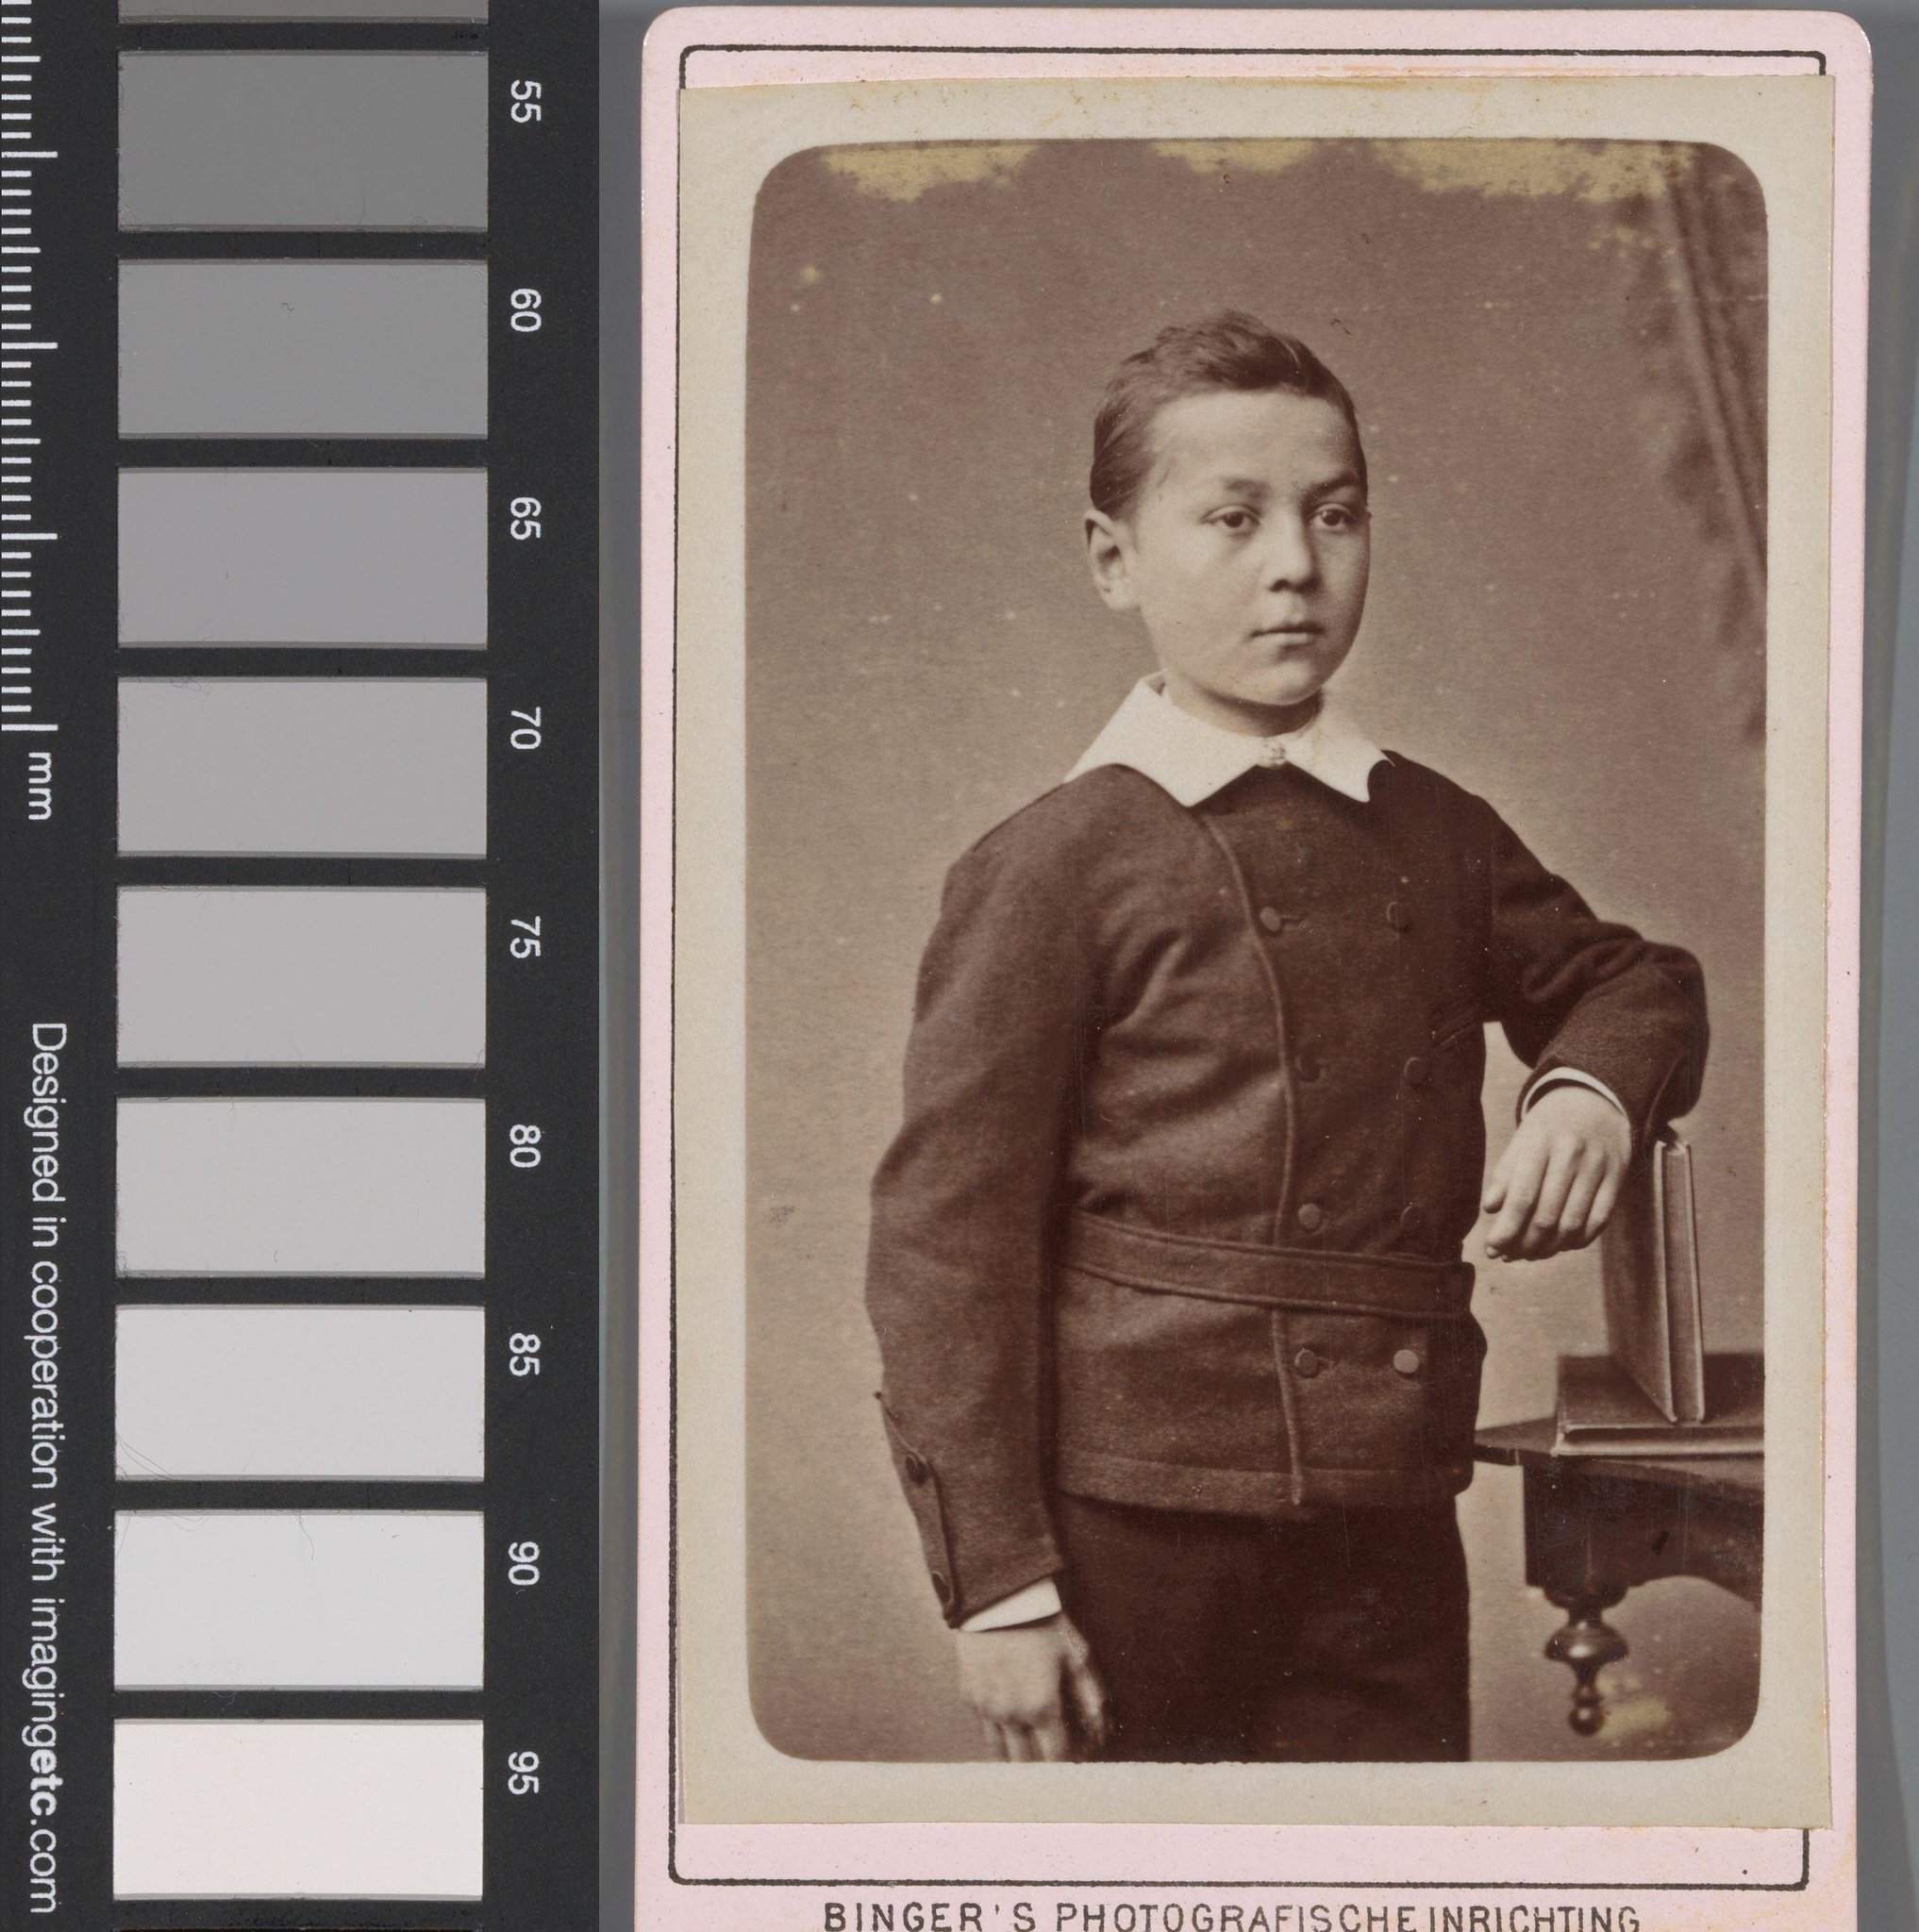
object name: semi enamel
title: Portret van een onbekende jongen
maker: charles binger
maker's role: print maker, printer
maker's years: 1830-1916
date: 1878-1887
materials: cardboard, celluloid, paper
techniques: albumen print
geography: haarlem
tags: boy (child between toddler and youth), anonymous historical person portrayed, haarlem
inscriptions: inscription: ‘Binger's/ Photographische Inrichting/ Oude Gracht/ Haarlem/ Groningen/ Bekroond/ Weenen’, inscription: ‘Binger's Photographische Inrichting/ Haarlem Oude Gracht’